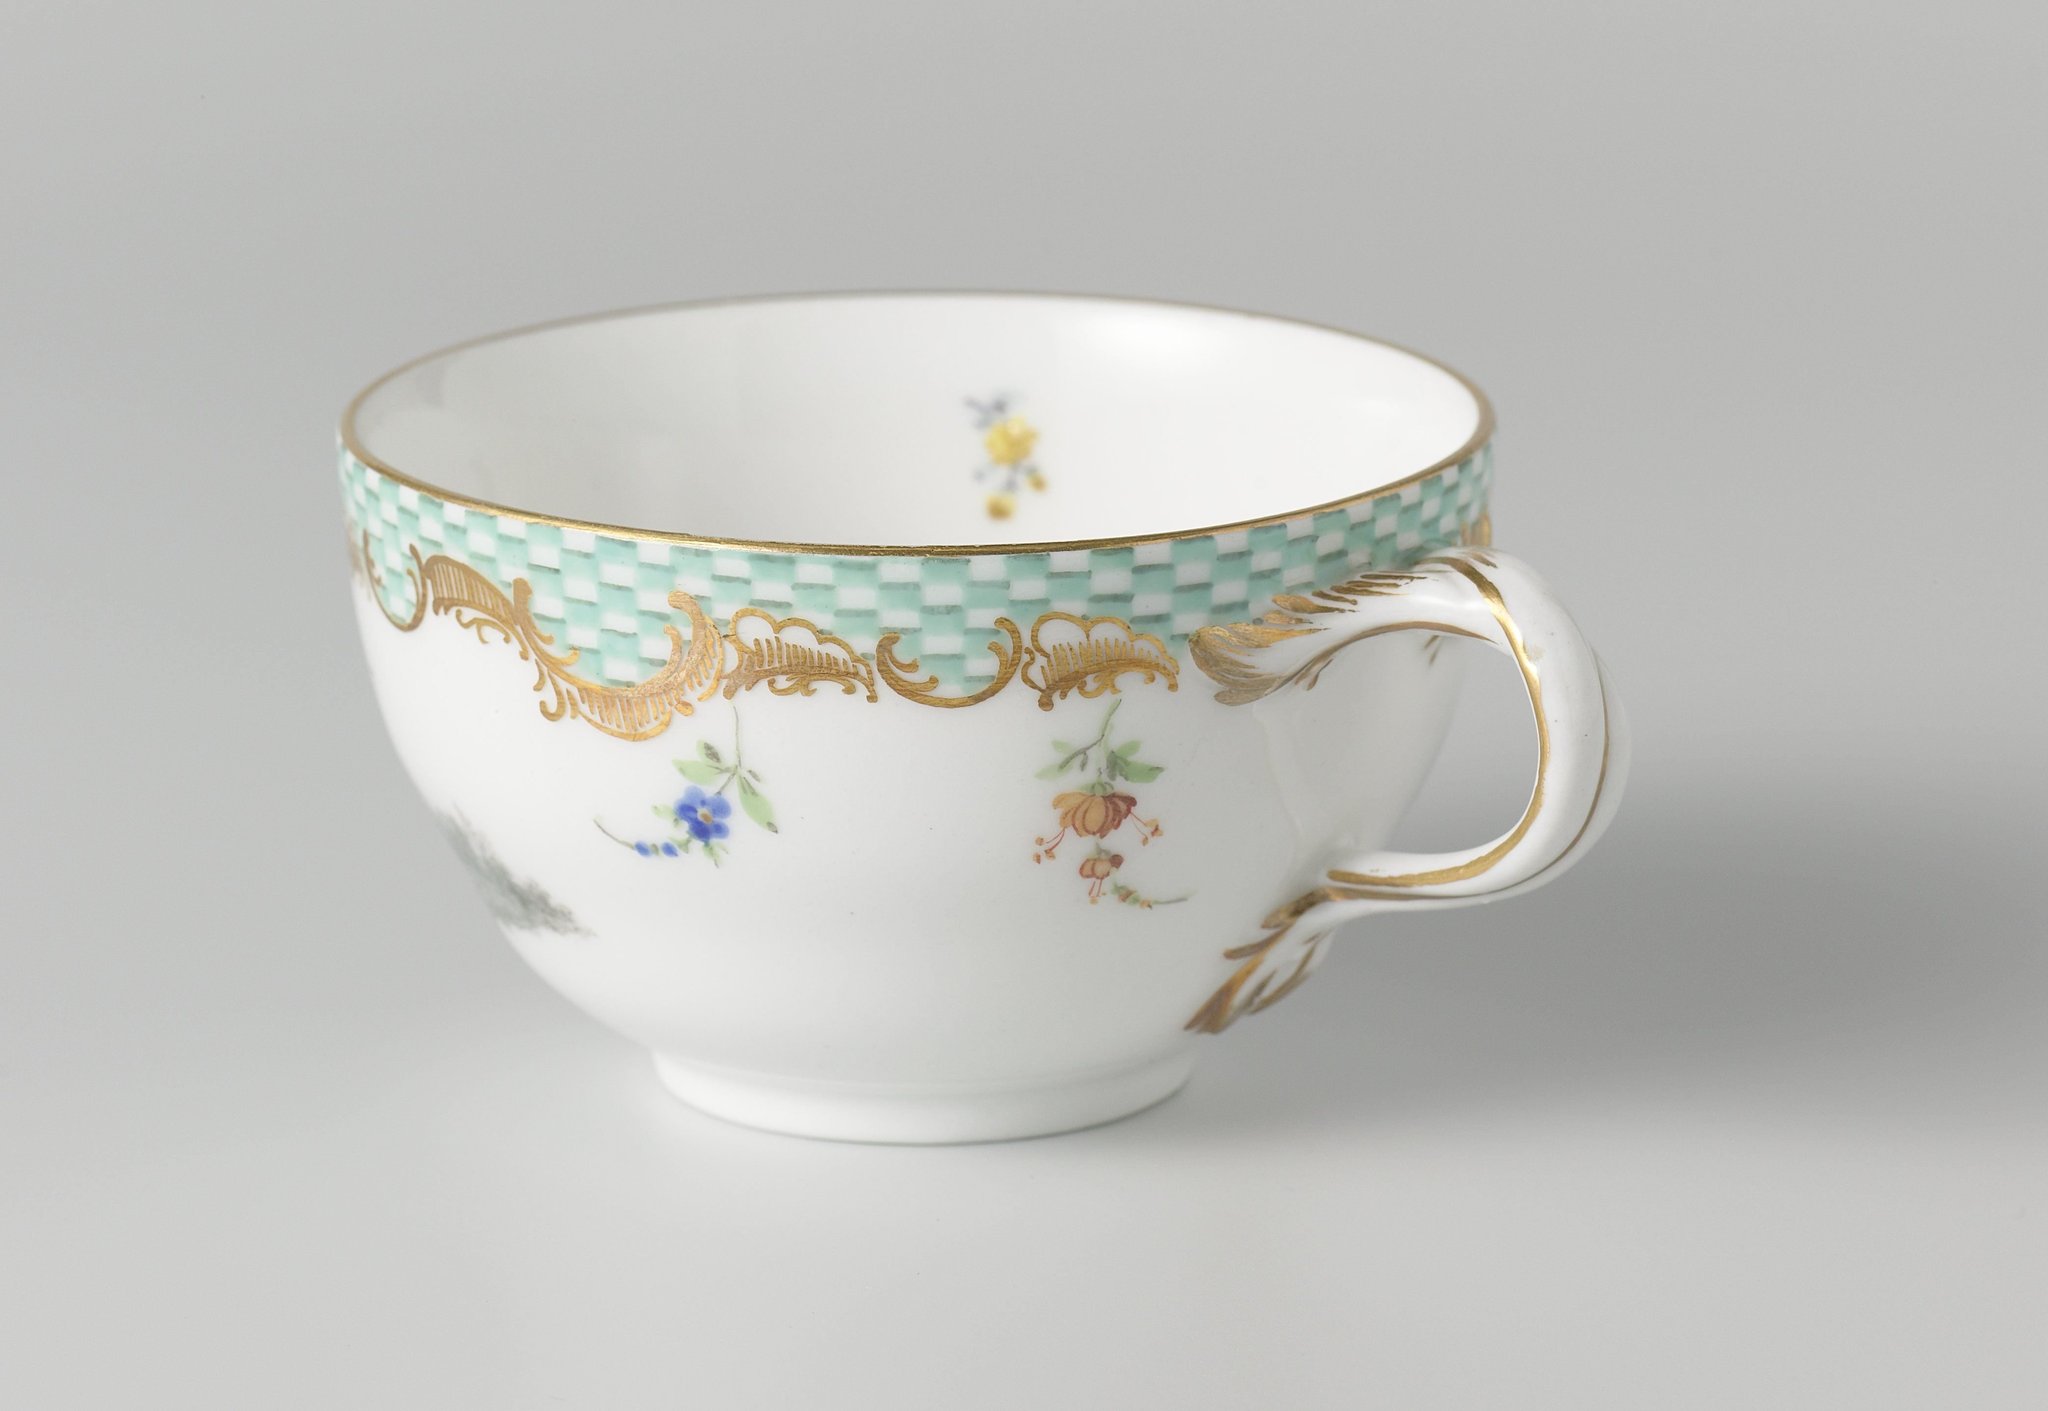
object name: cup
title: Kop, veelkleurig beschilderd met een landschap met figuren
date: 1777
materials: porcelain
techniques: painted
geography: meissen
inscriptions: mold mark: ‘18’, factory mark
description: Lage kop met oor, van beschilderd porselein. De kop is beschilderd met landschappen waarin figuren en langs de rand een brede strook groen vlechtwerk. De kop is gemerkt.